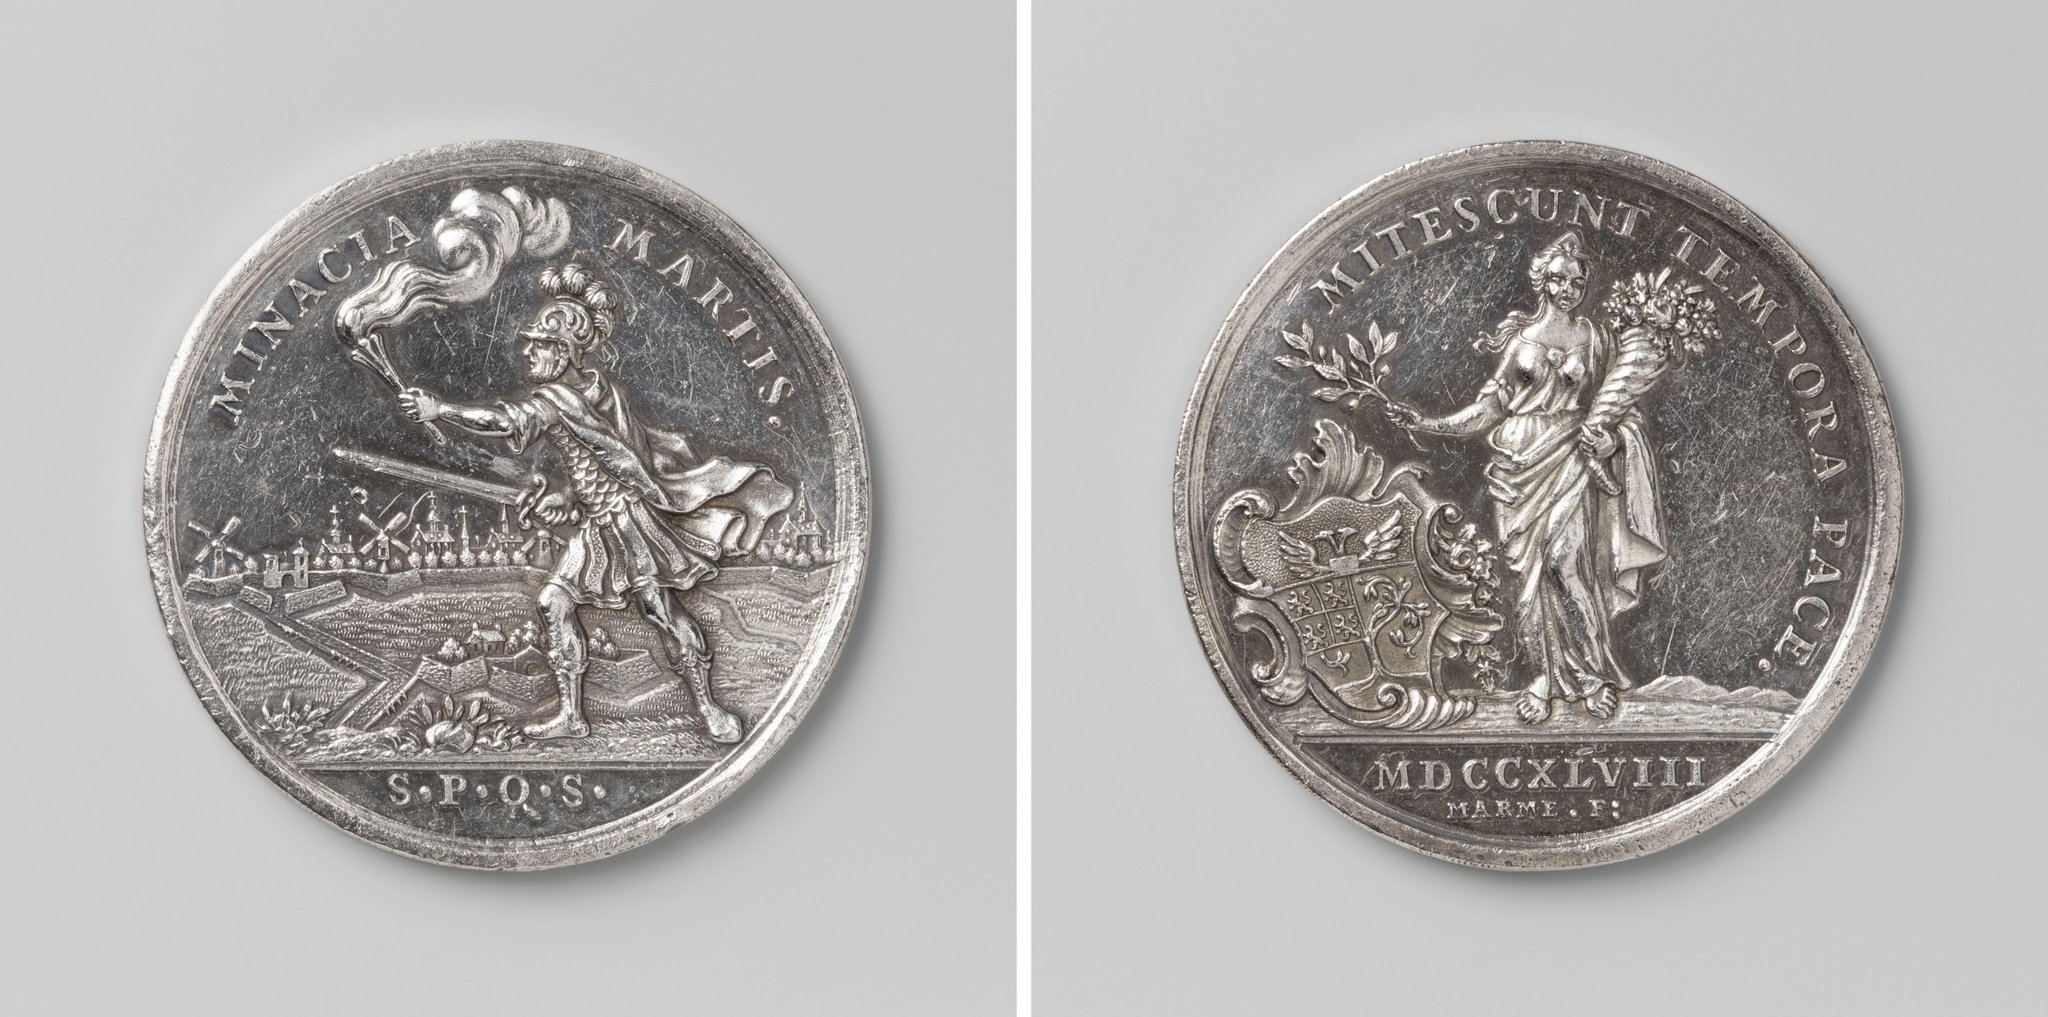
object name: council medal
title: 's-Hertogenbosch, vroedschapspenning op de vrede van Aken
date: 1748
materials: silver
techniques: striking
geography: den bosch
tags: den bosch